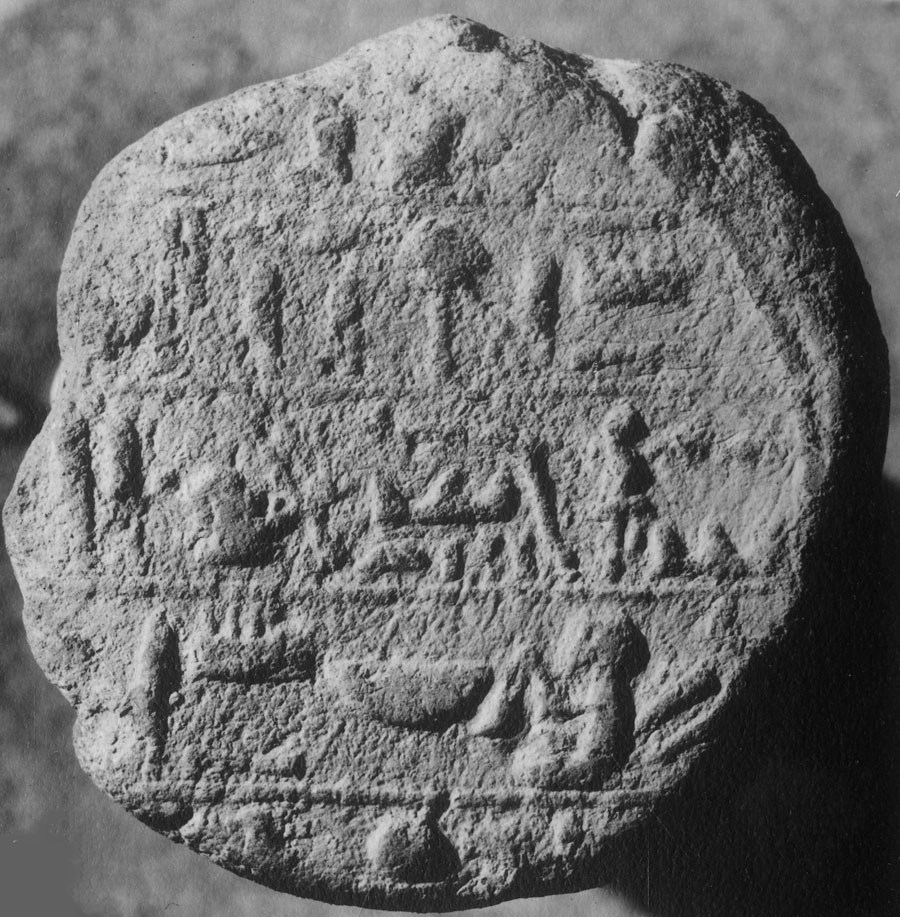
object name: cone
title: Funerary Cone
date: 1550-1295 BCE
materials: pottery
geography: egypt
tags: hieroglyphs